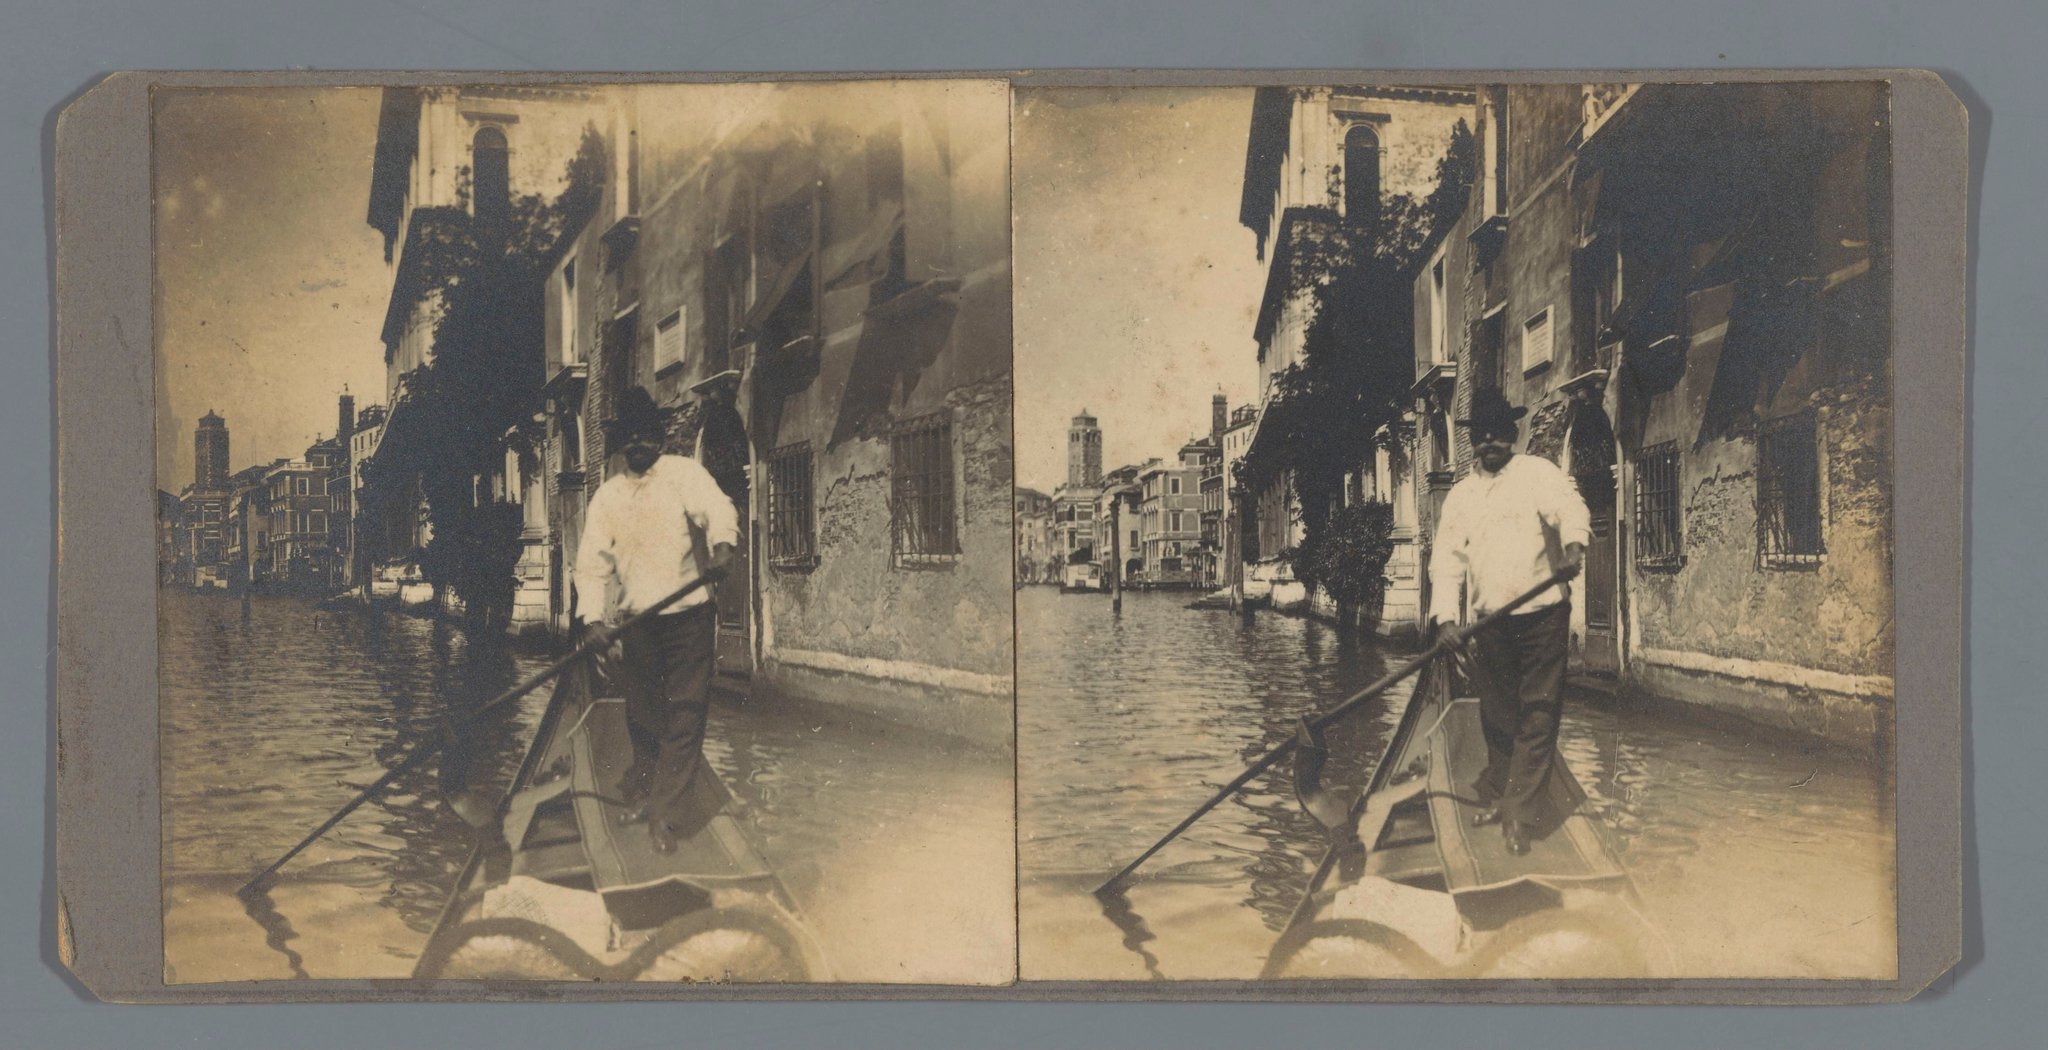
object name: stereograph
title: Gondelier te Venetië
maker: Anonymous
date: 1890-1920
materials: cardboard, photographic support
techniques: gelatin silver print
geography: venice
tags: canal, gondola, venice